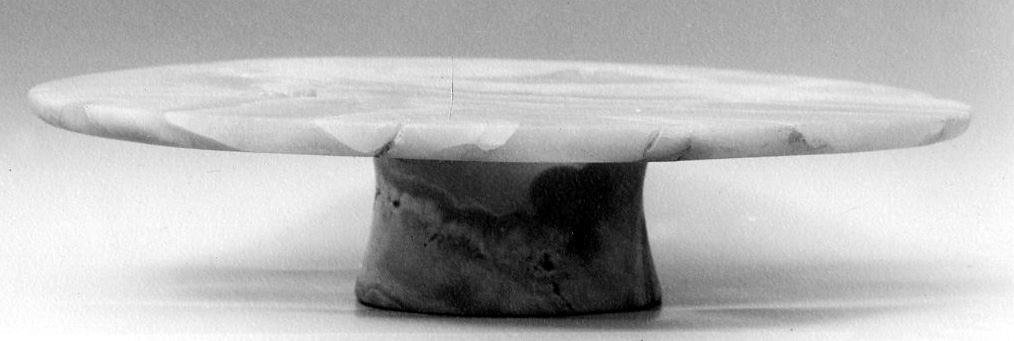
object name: offering table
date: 2323-2150 BCE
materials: stone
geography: egypt